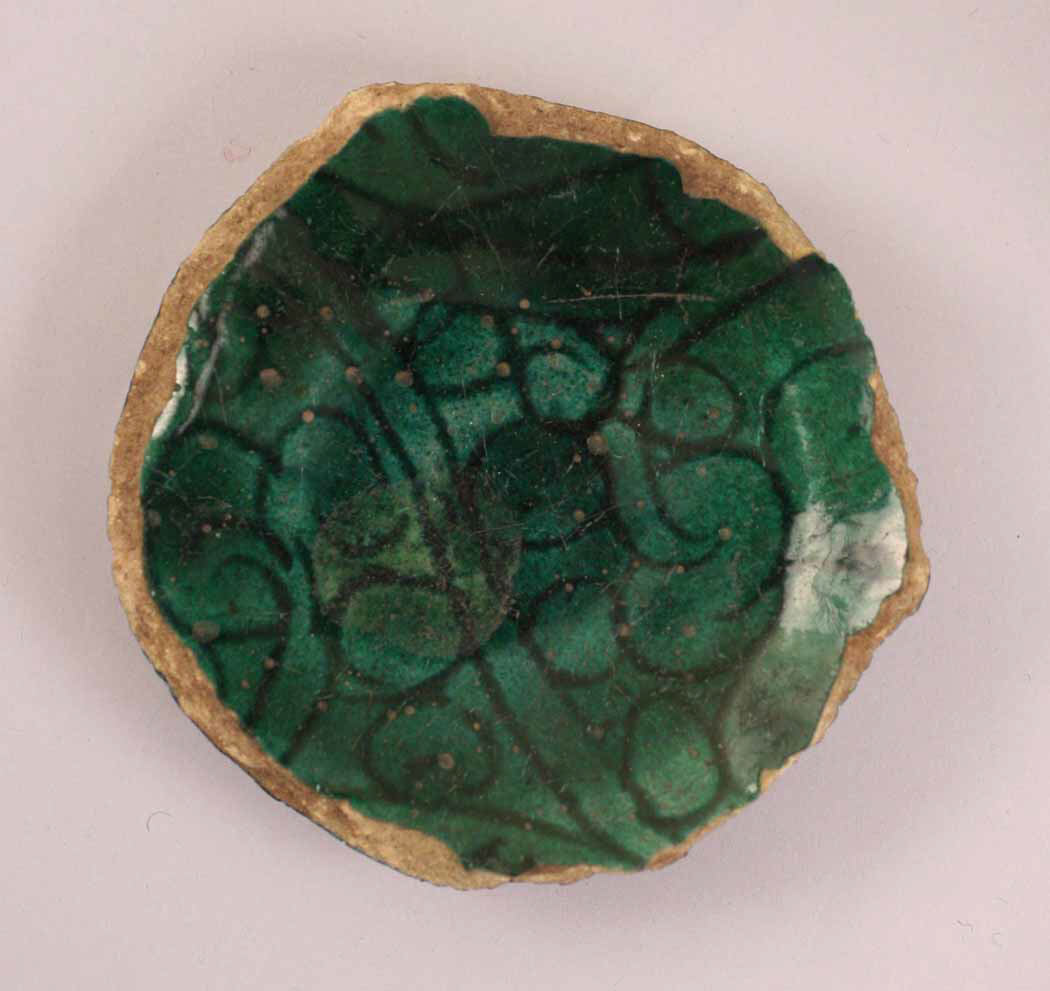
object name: ceramic fragment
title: Fragment of a Bowl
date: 1201-1400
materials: earthenware, glaze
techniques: incising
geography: egypt